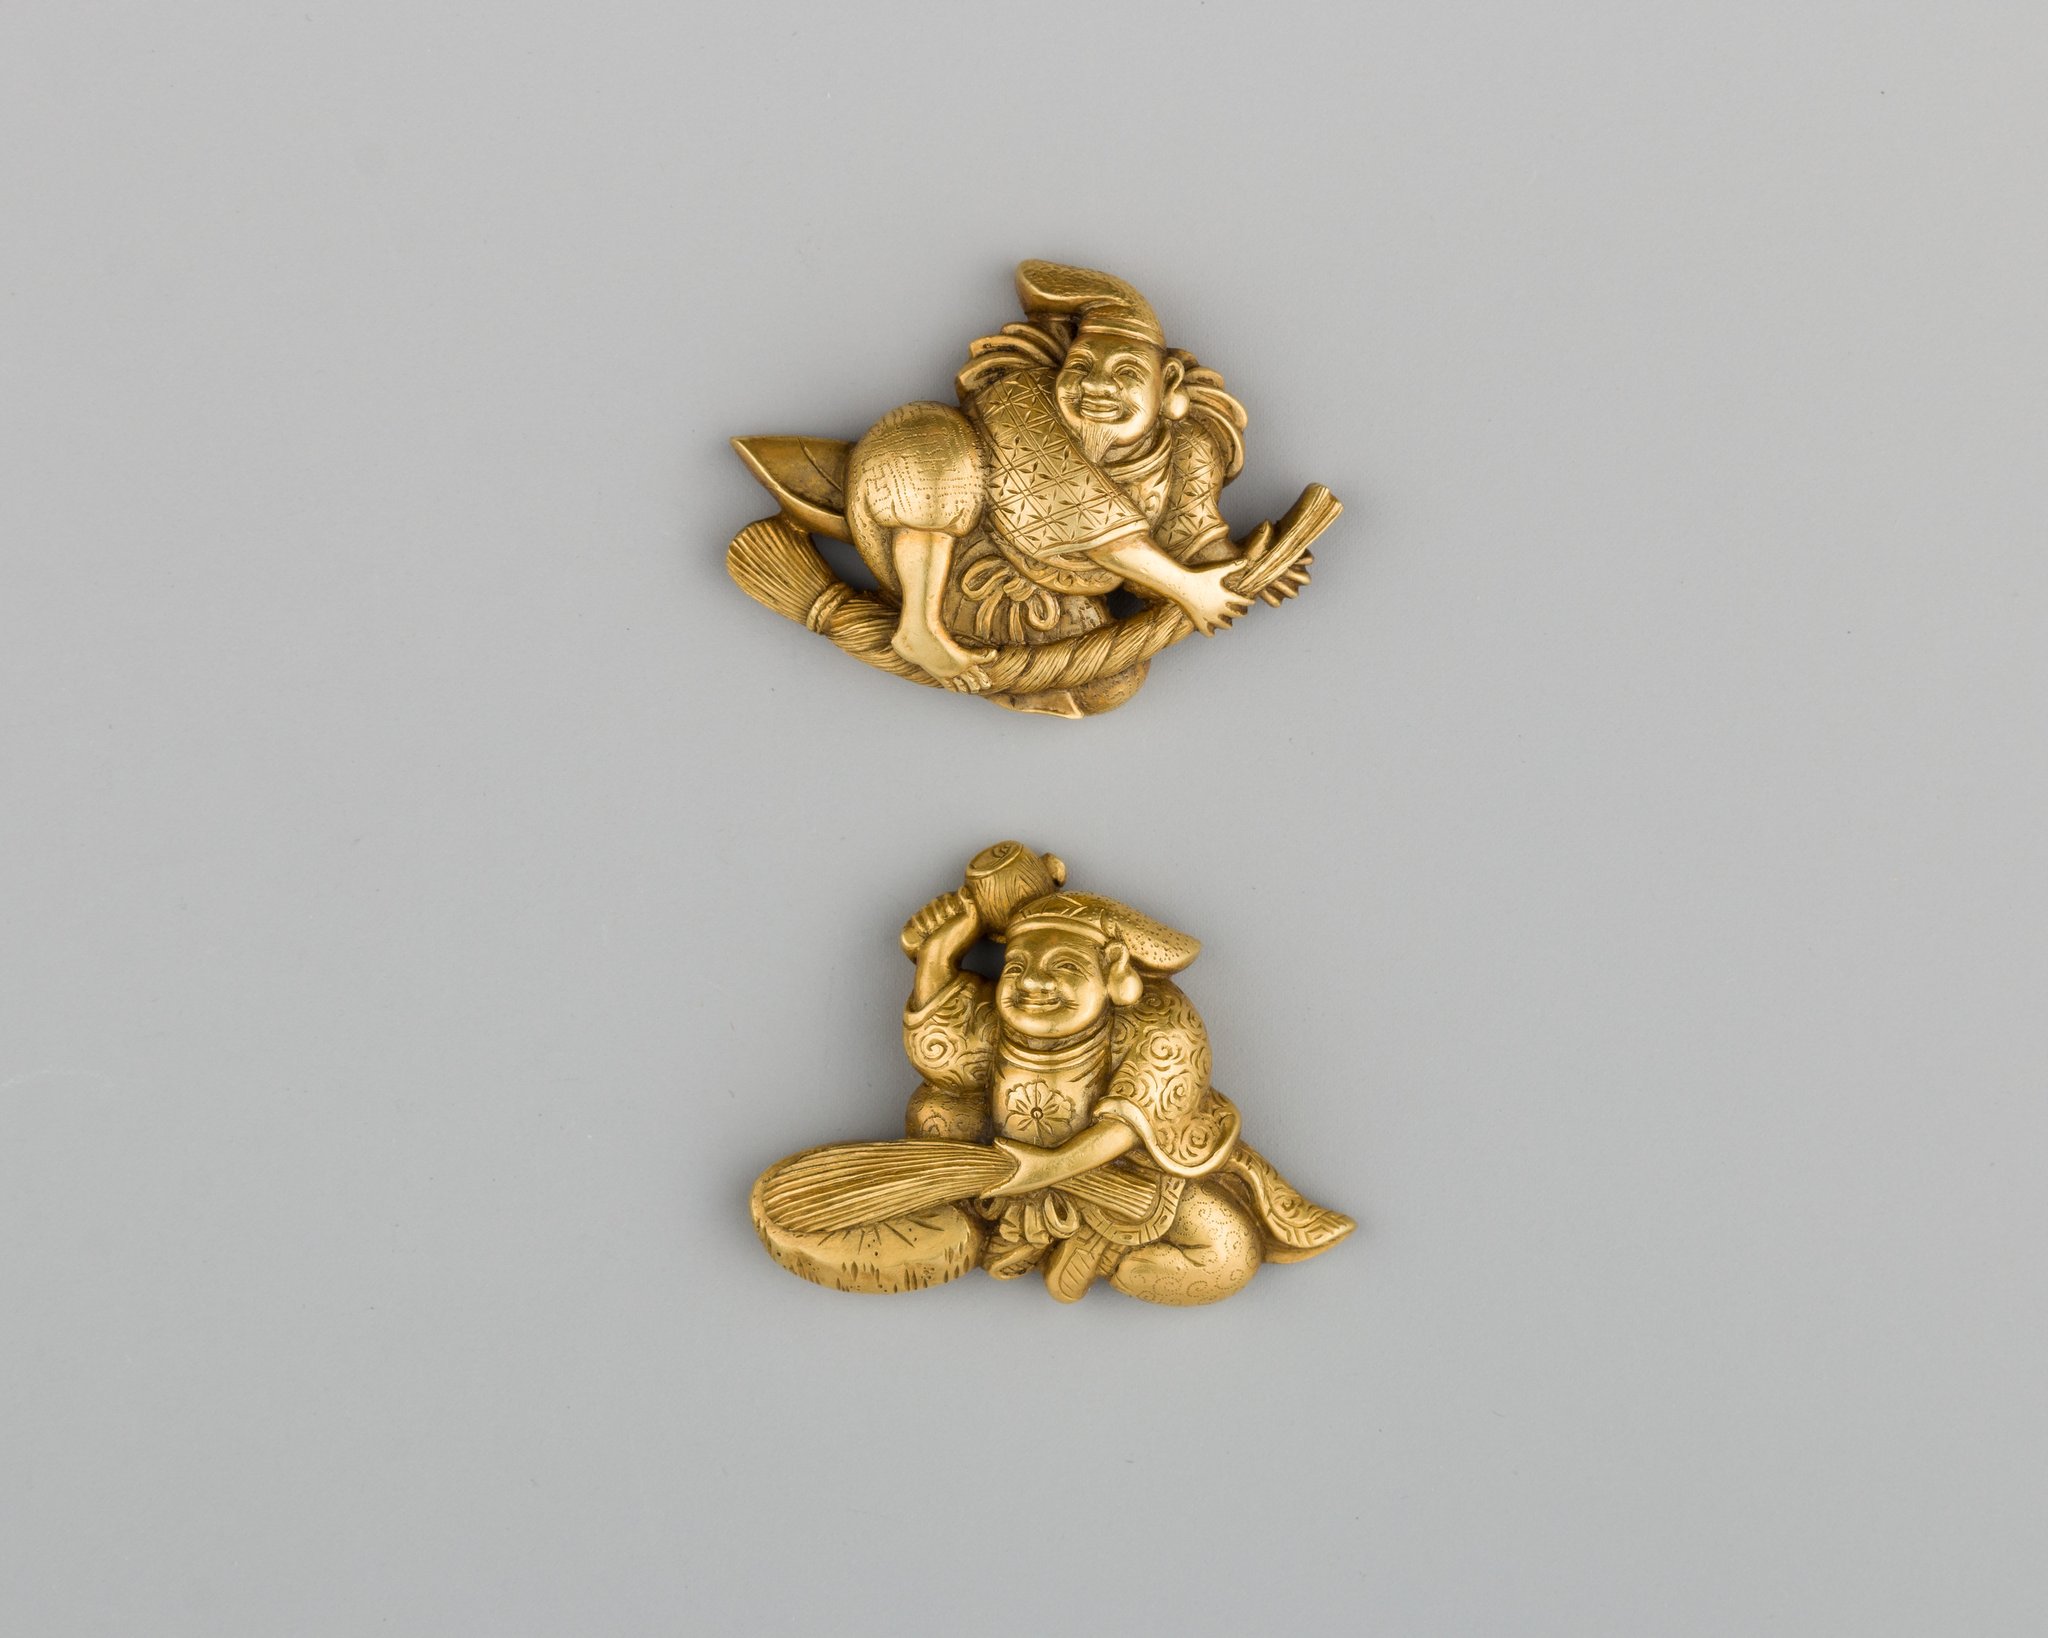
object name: pair of sword grip ornament menuki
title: Pair of Sword-Grip Ornaments (Menuki)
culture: japanese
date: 1701-1800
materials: gold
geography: japan